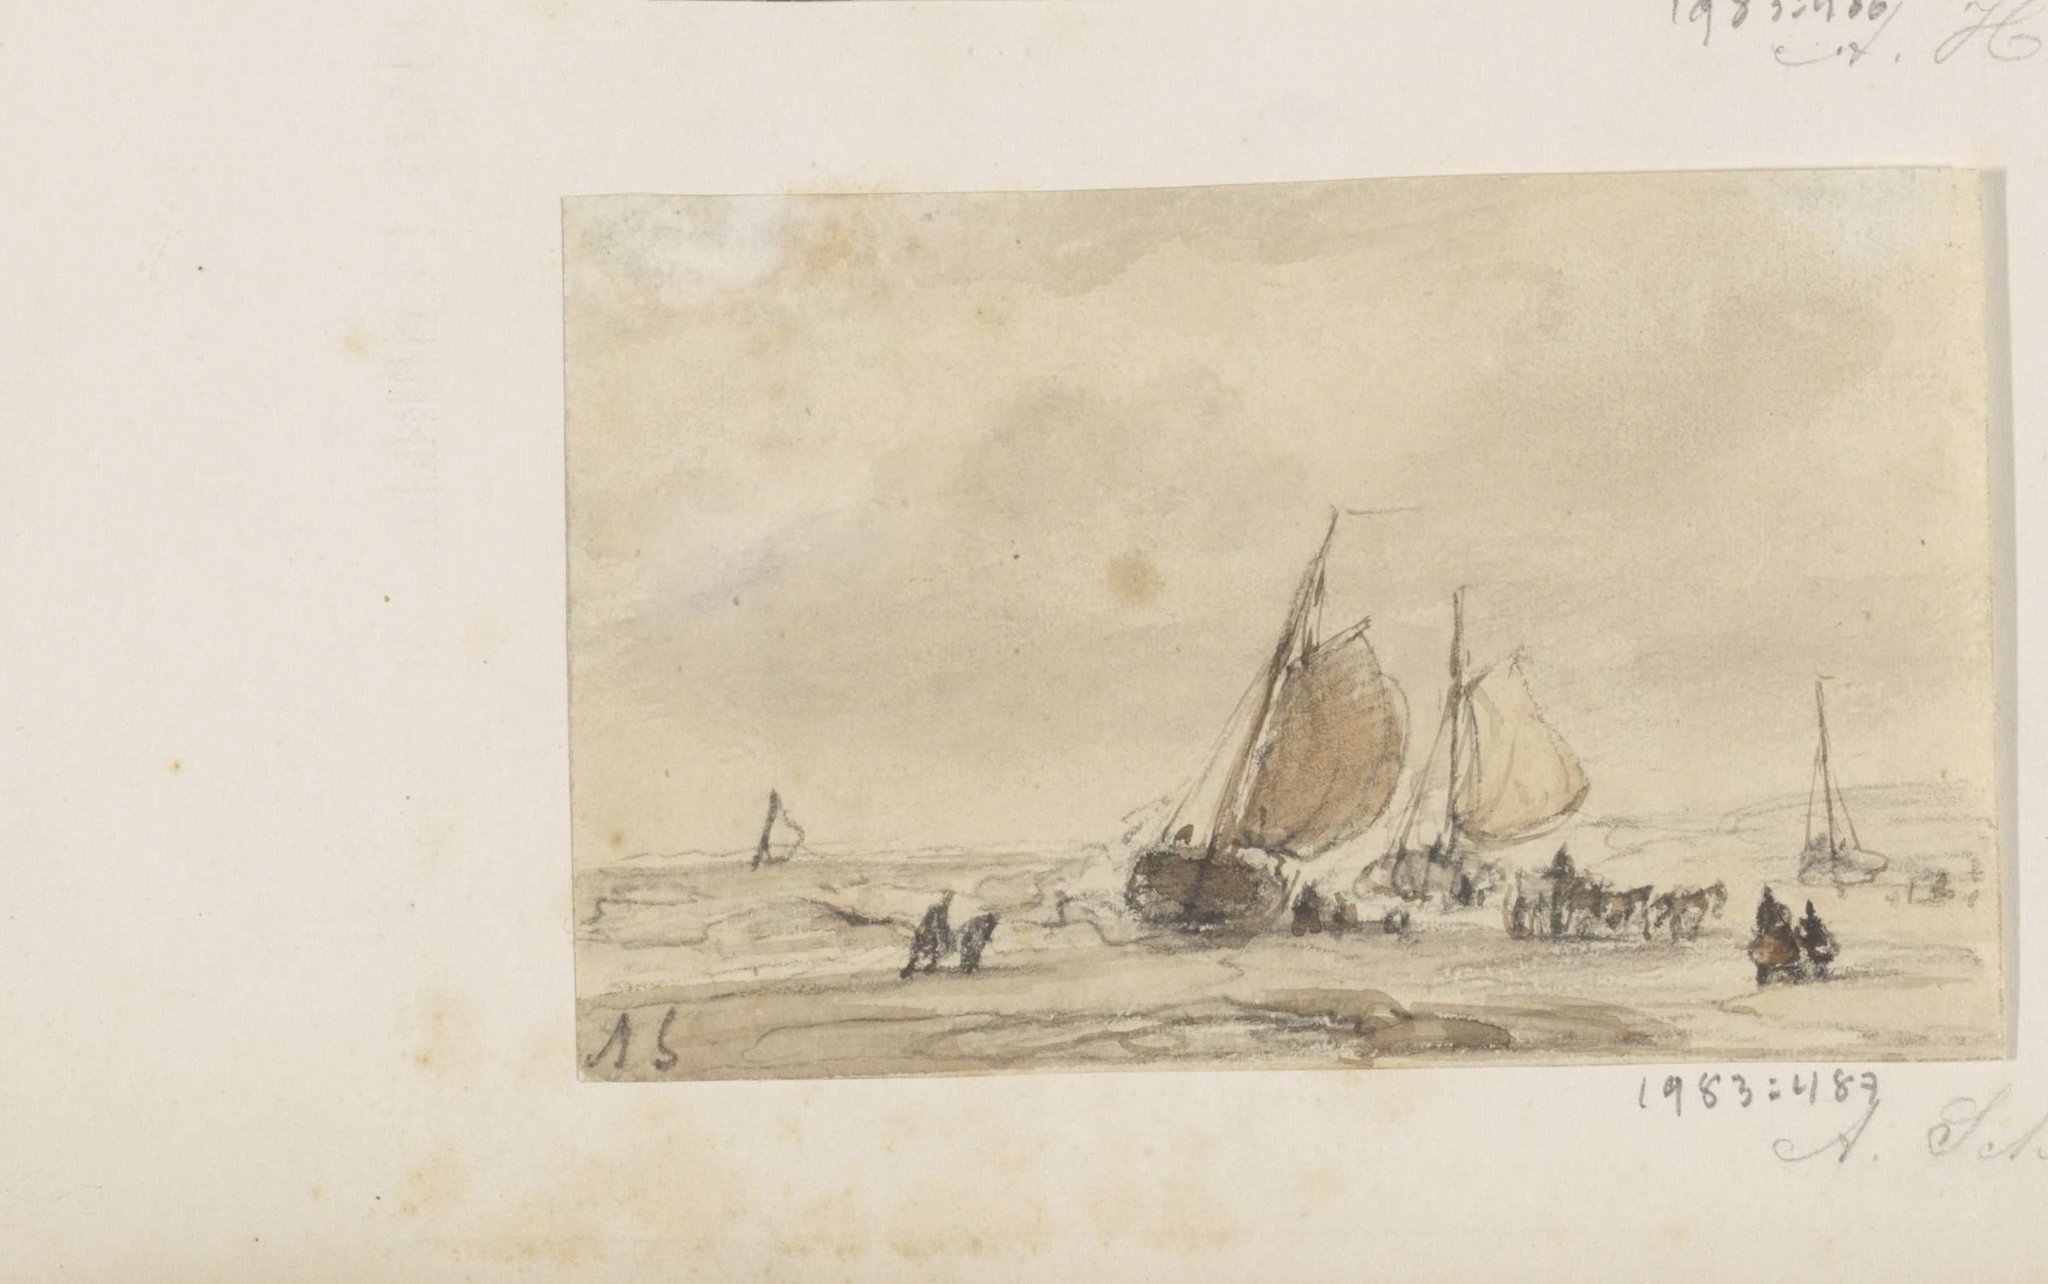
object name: album leaf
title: Zeilschepen en figuren op een strand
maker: andreas schelfhout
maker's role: draughtsman, painter, print maker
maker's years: 1787-1870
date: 1797-1870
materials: chalk, paper, watercolor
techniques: brush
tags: sailing-ship, sailing-boat, beach (+ landscape with figures, staffage)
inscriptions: signature: ‘AS’